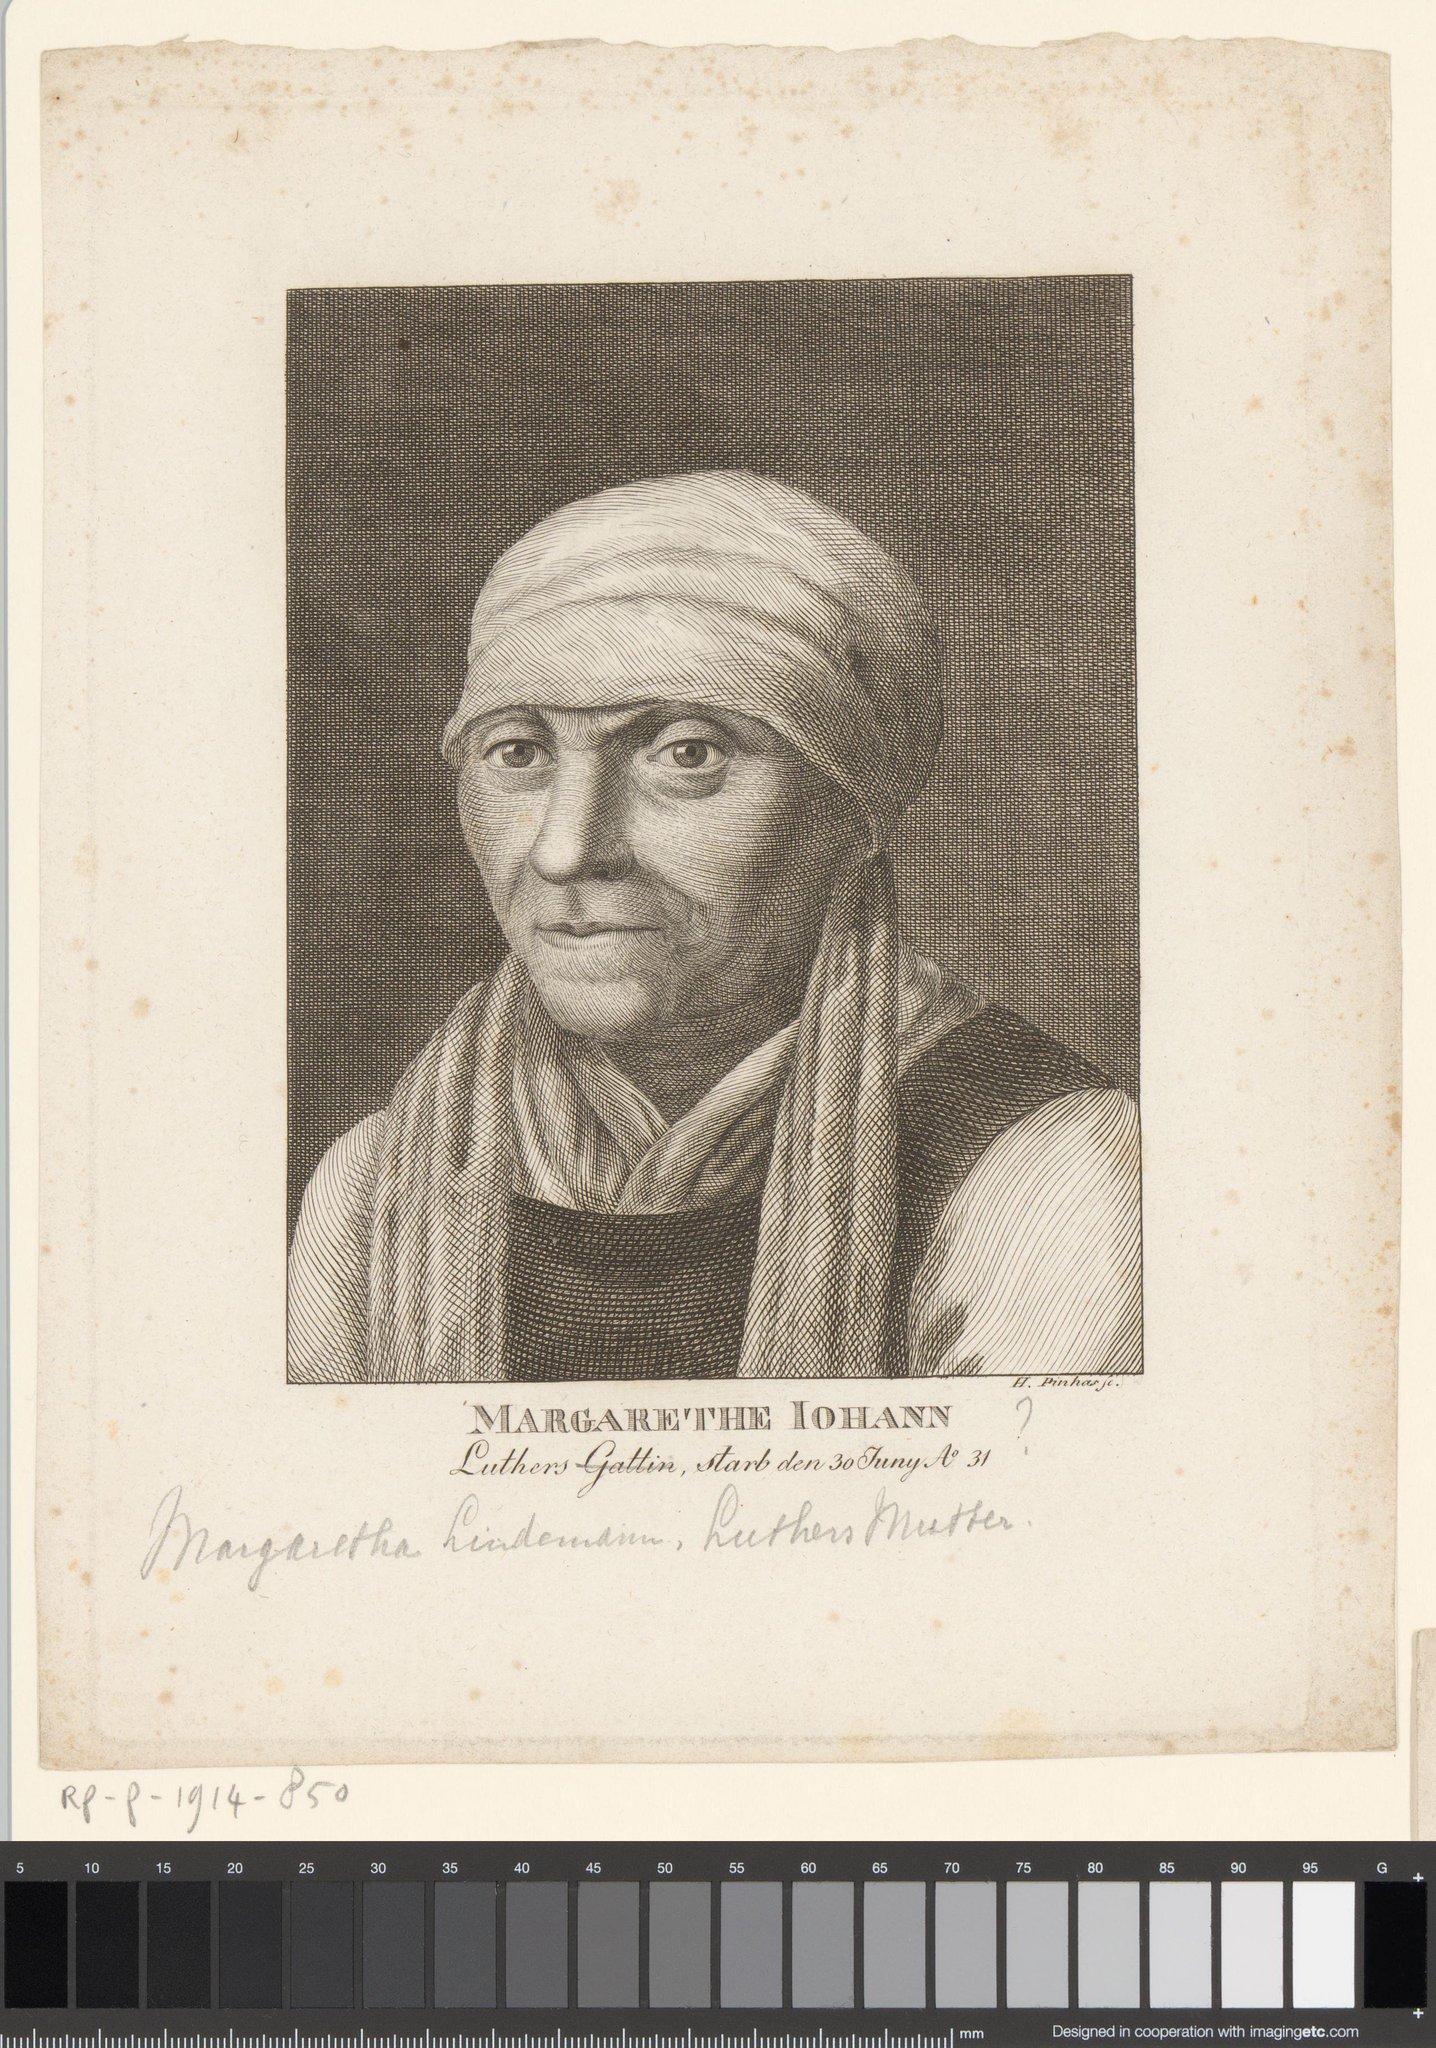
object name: print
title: Portret van Margarethe Luther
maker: hermann hirsch pinhas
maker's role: print maker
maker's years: 1795-1844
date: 1805-1844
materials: paper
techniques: engraving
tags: historical persons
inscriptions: collector's mark: Lugt 2228